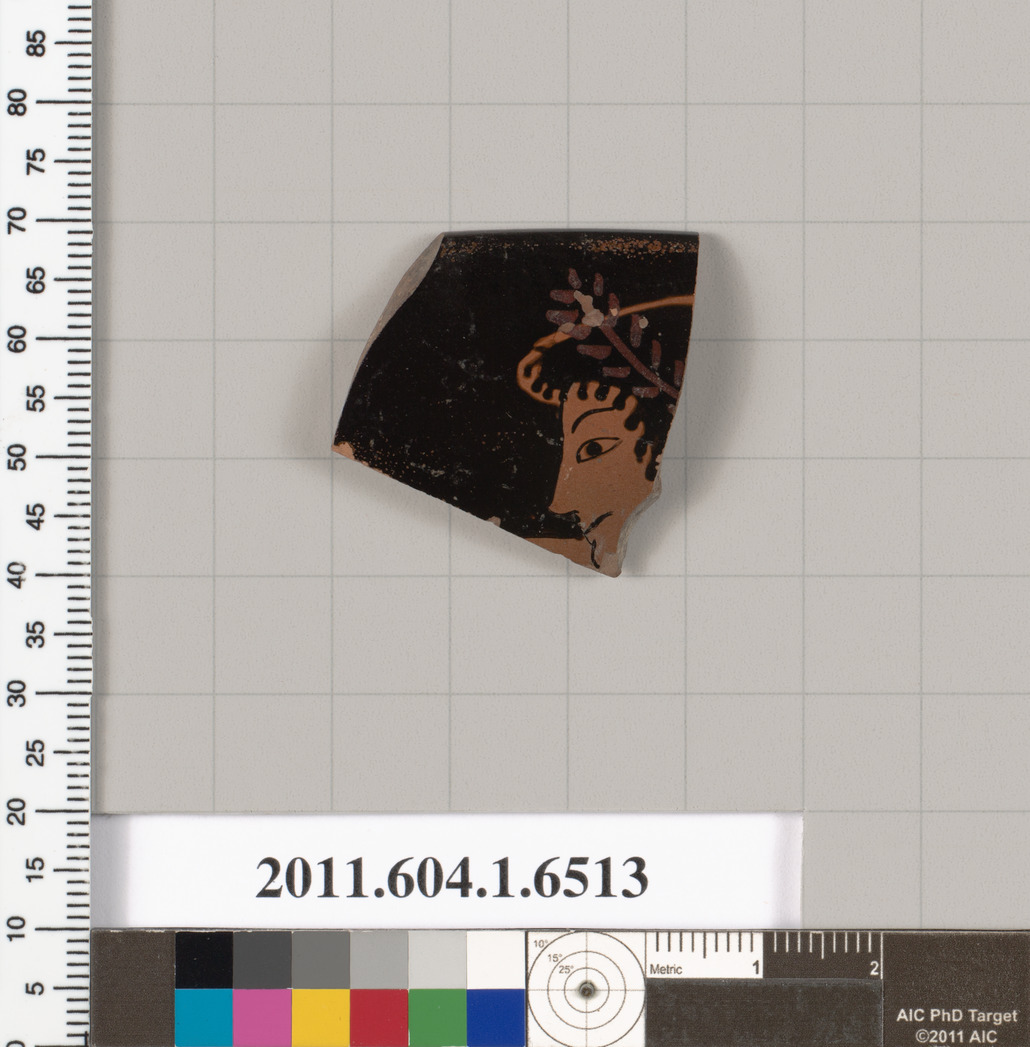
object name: kylix fragment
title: Terracotta rim fragment of a kylix (drinking cup)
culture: greek, attic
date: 490-480 BCE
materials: terracotta